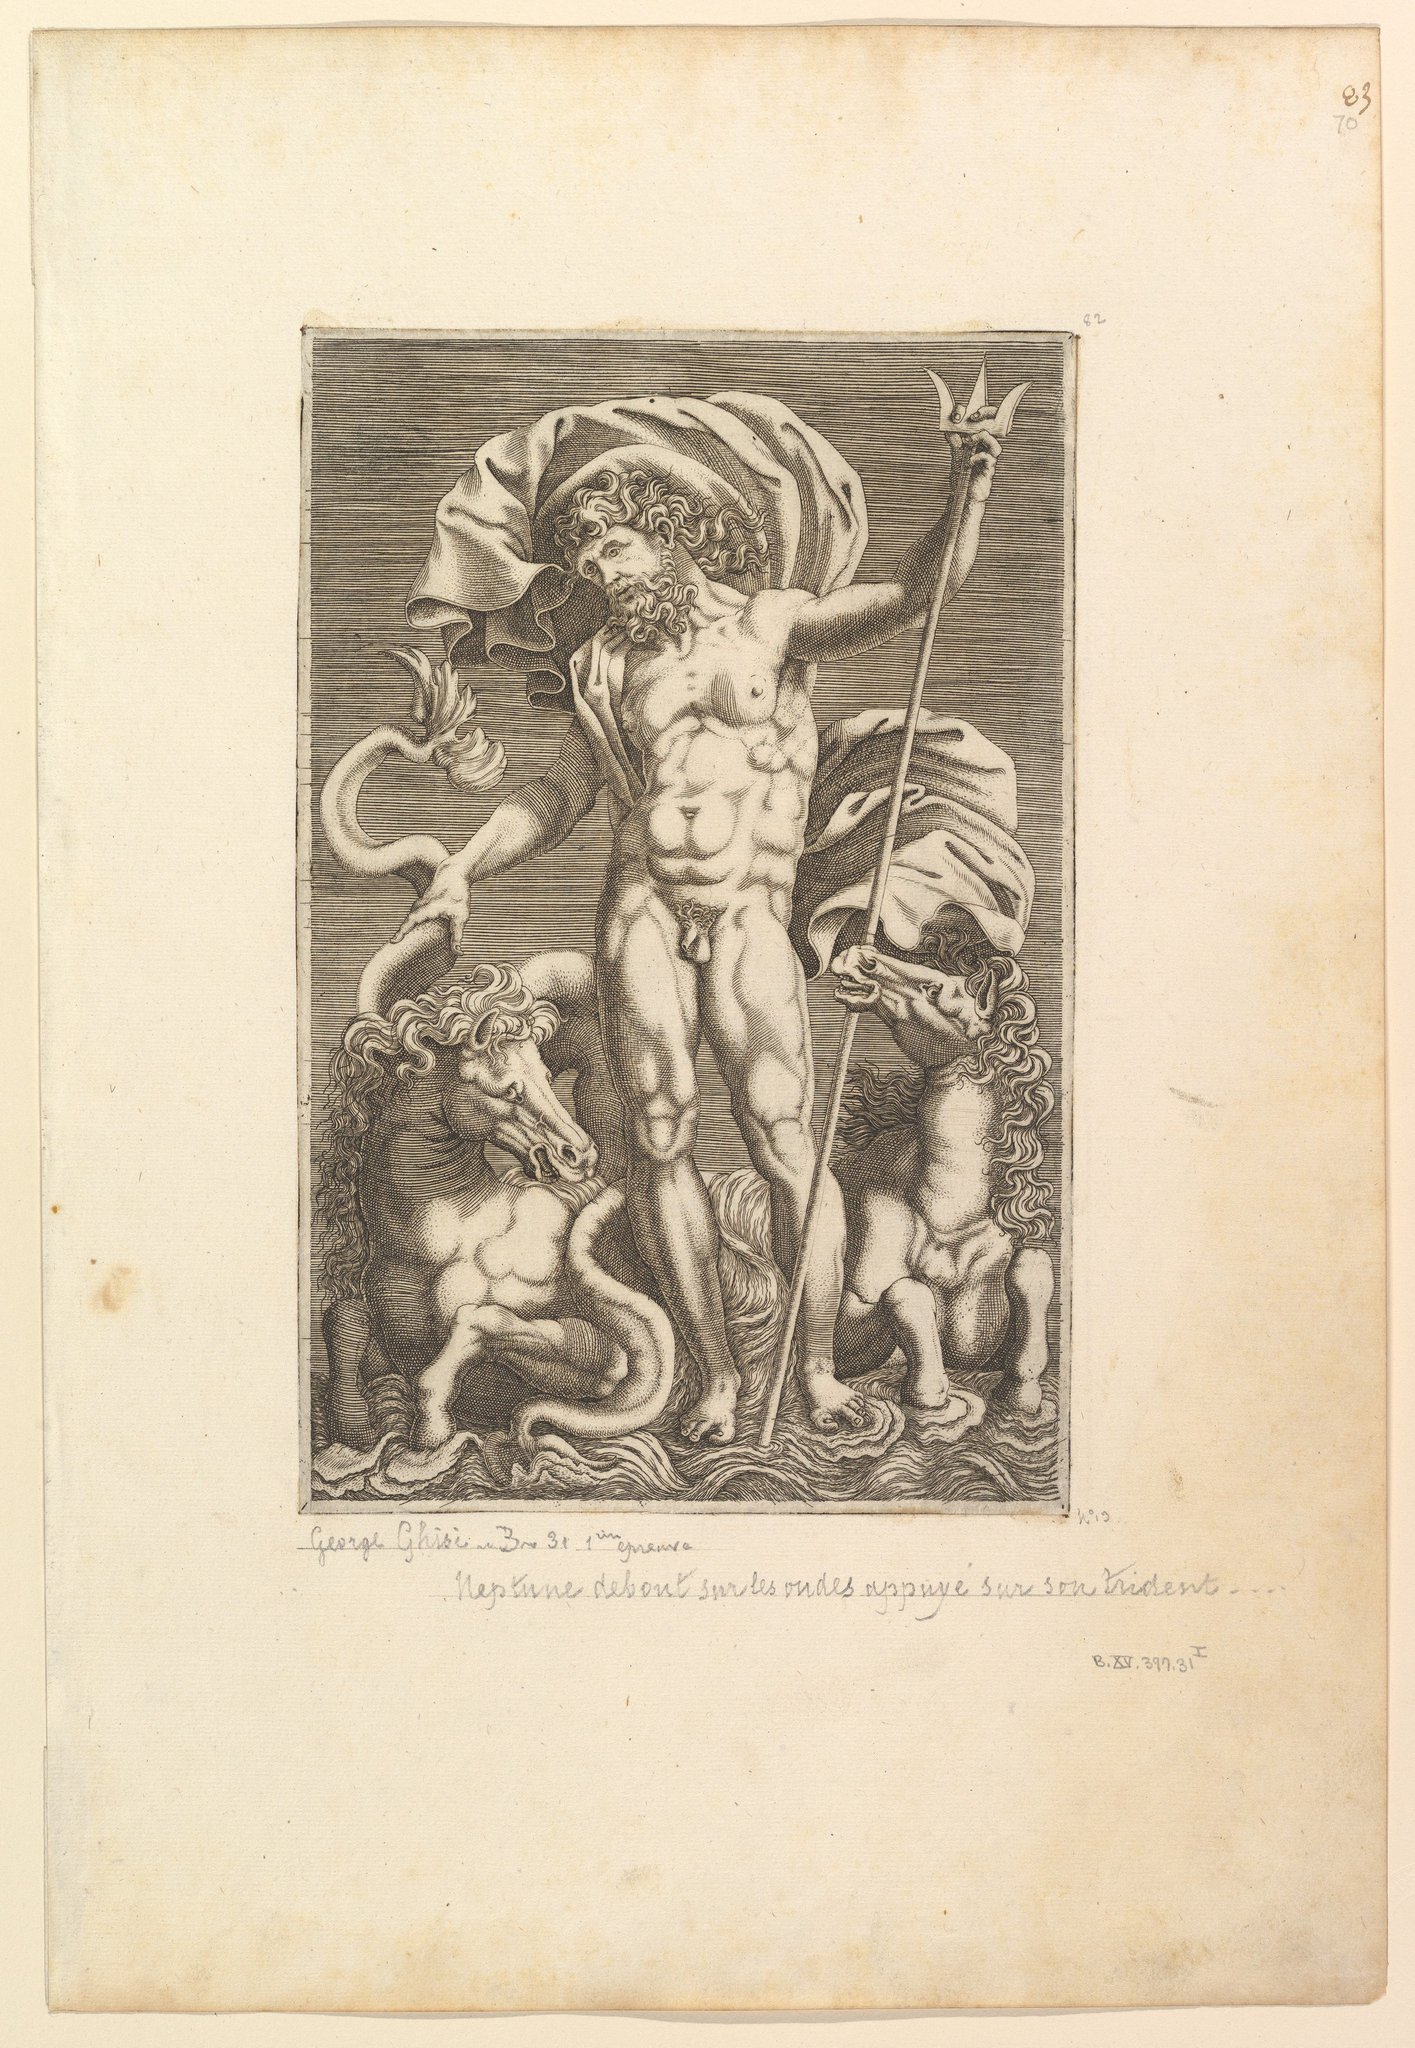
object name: print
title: Neptune Between Two Sea Horses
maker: anonymous, italian?, 16th century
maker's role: artist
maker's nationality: italian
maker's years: 1500-1600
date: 1560-1580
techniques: engraving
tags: neptune,fish